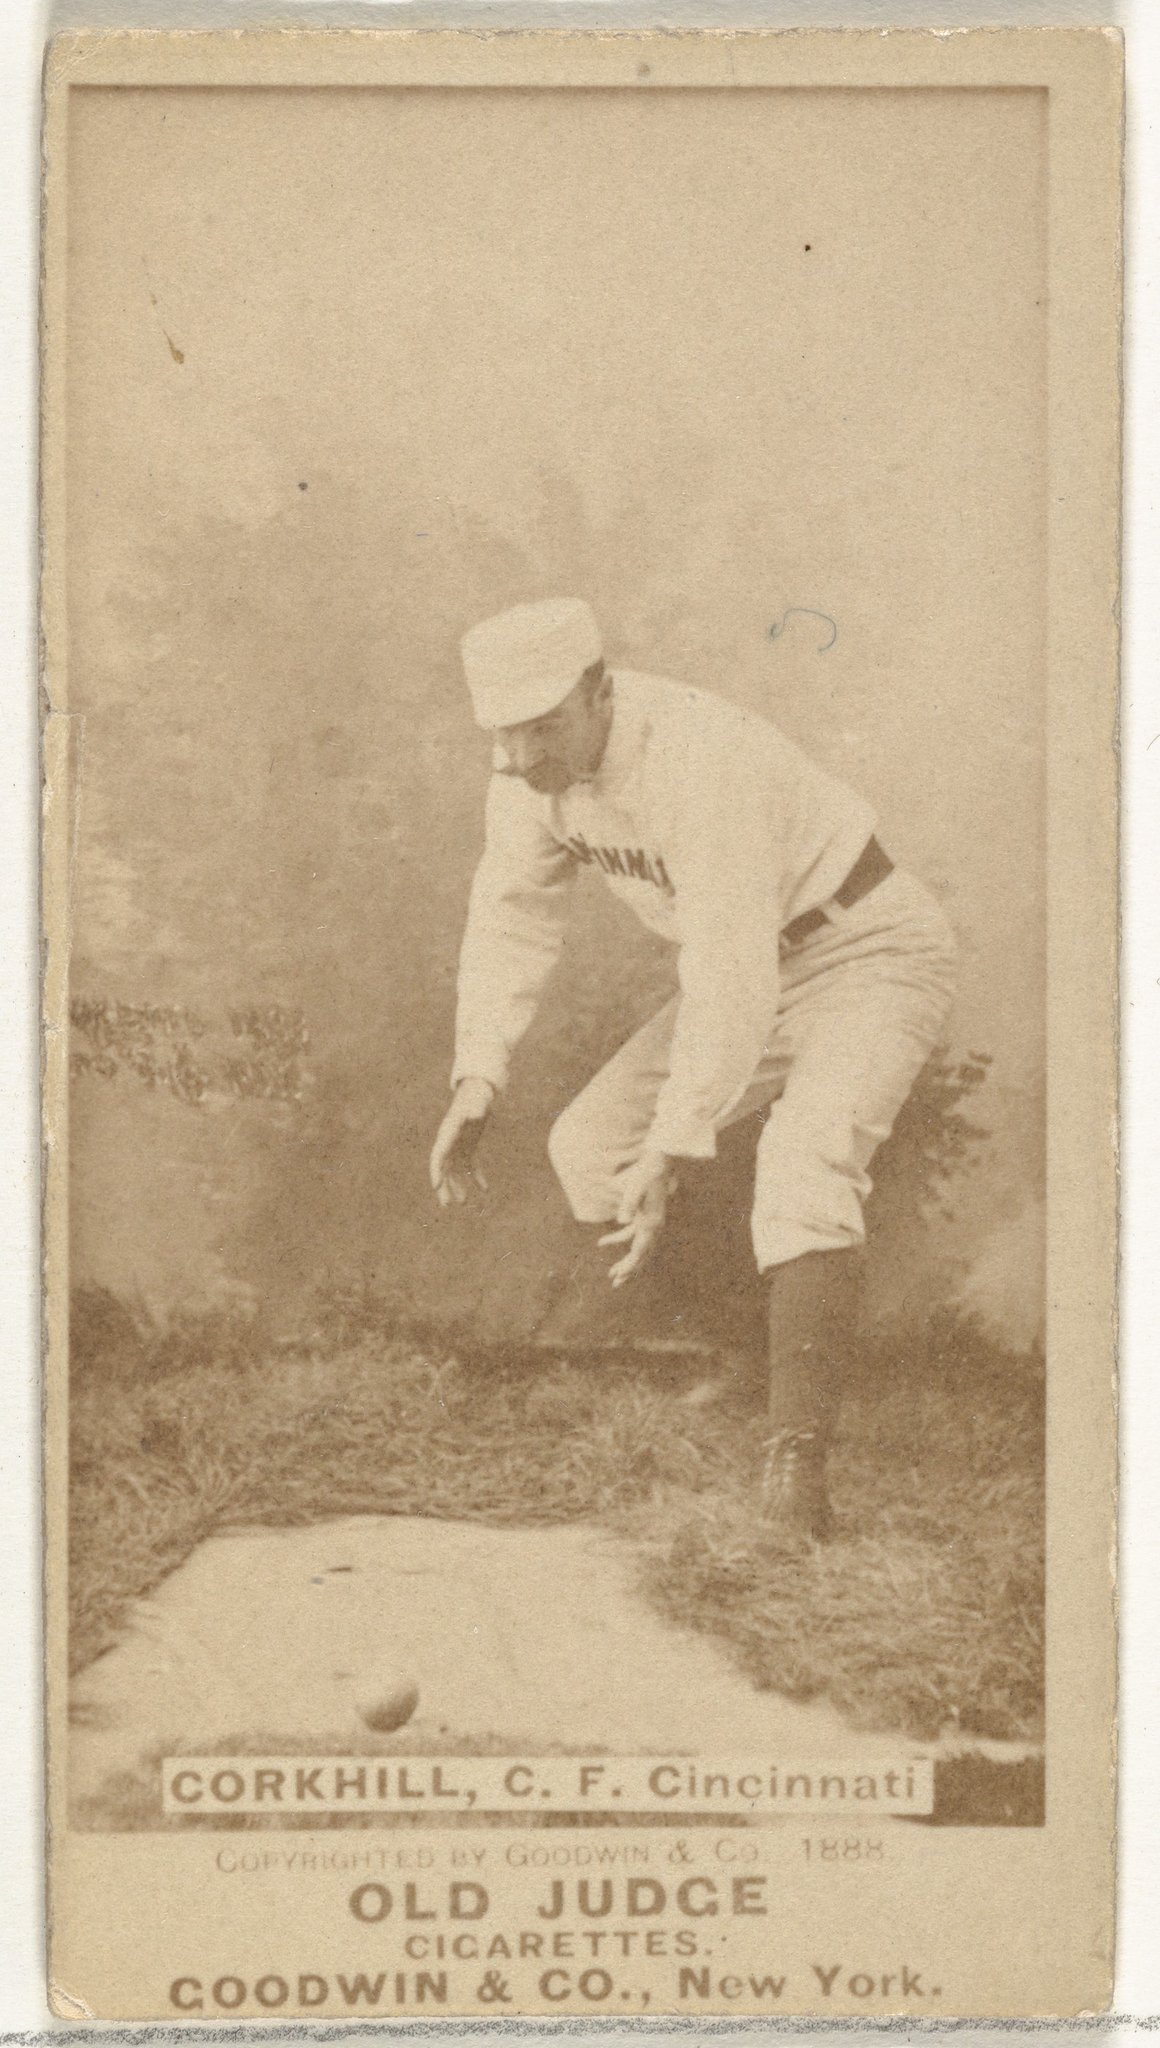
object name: baseball card, photograph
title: John Stewart "Pop" Corkhill, Center Field, Cincinnati, from the Old Judge series (N172) for Old Judge Cigarettes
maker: goodwin & company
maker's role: publisher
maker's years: 1850-1950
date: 1888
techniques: albumen silver print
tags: men,portraits,baseball,athletes